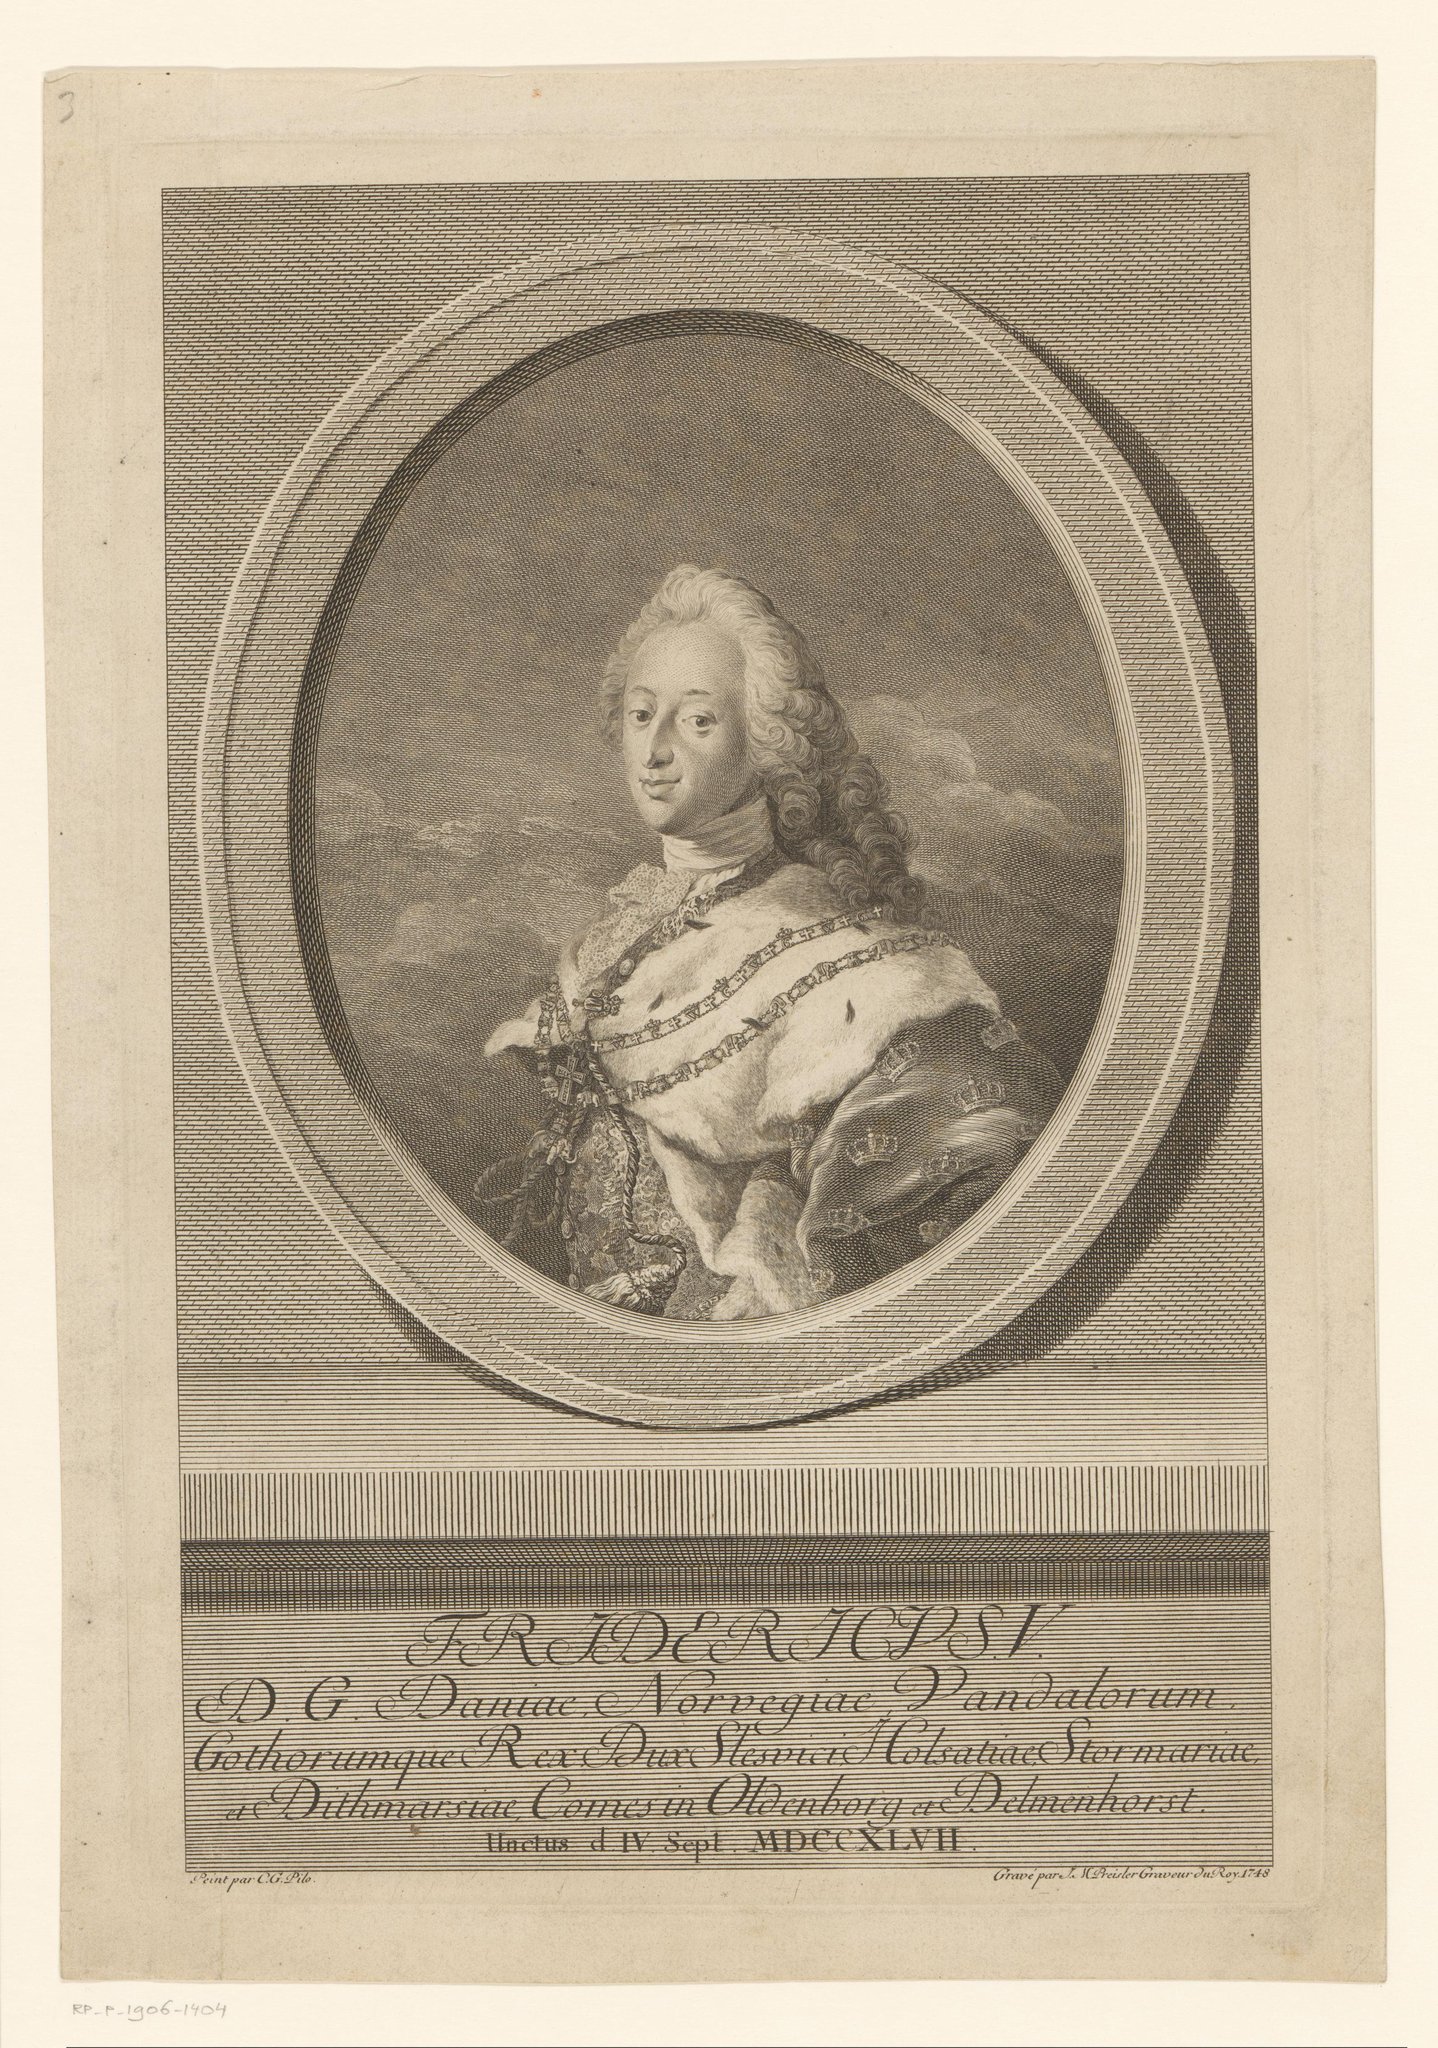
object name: print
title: Portret van Frederik IV, koning van Denemarken en Noorwegen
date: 1748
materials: paper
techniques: engraving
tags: copenhagen (city), frederik iv (koning van denemarken en noorwegen), historical persons, insignia and symbols of sovereignty (crown, diadem, sceptre, orb, seal, standard, cloak, pectoral), knighthood order (elephant)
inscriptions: collector's mark: Lugt 2228